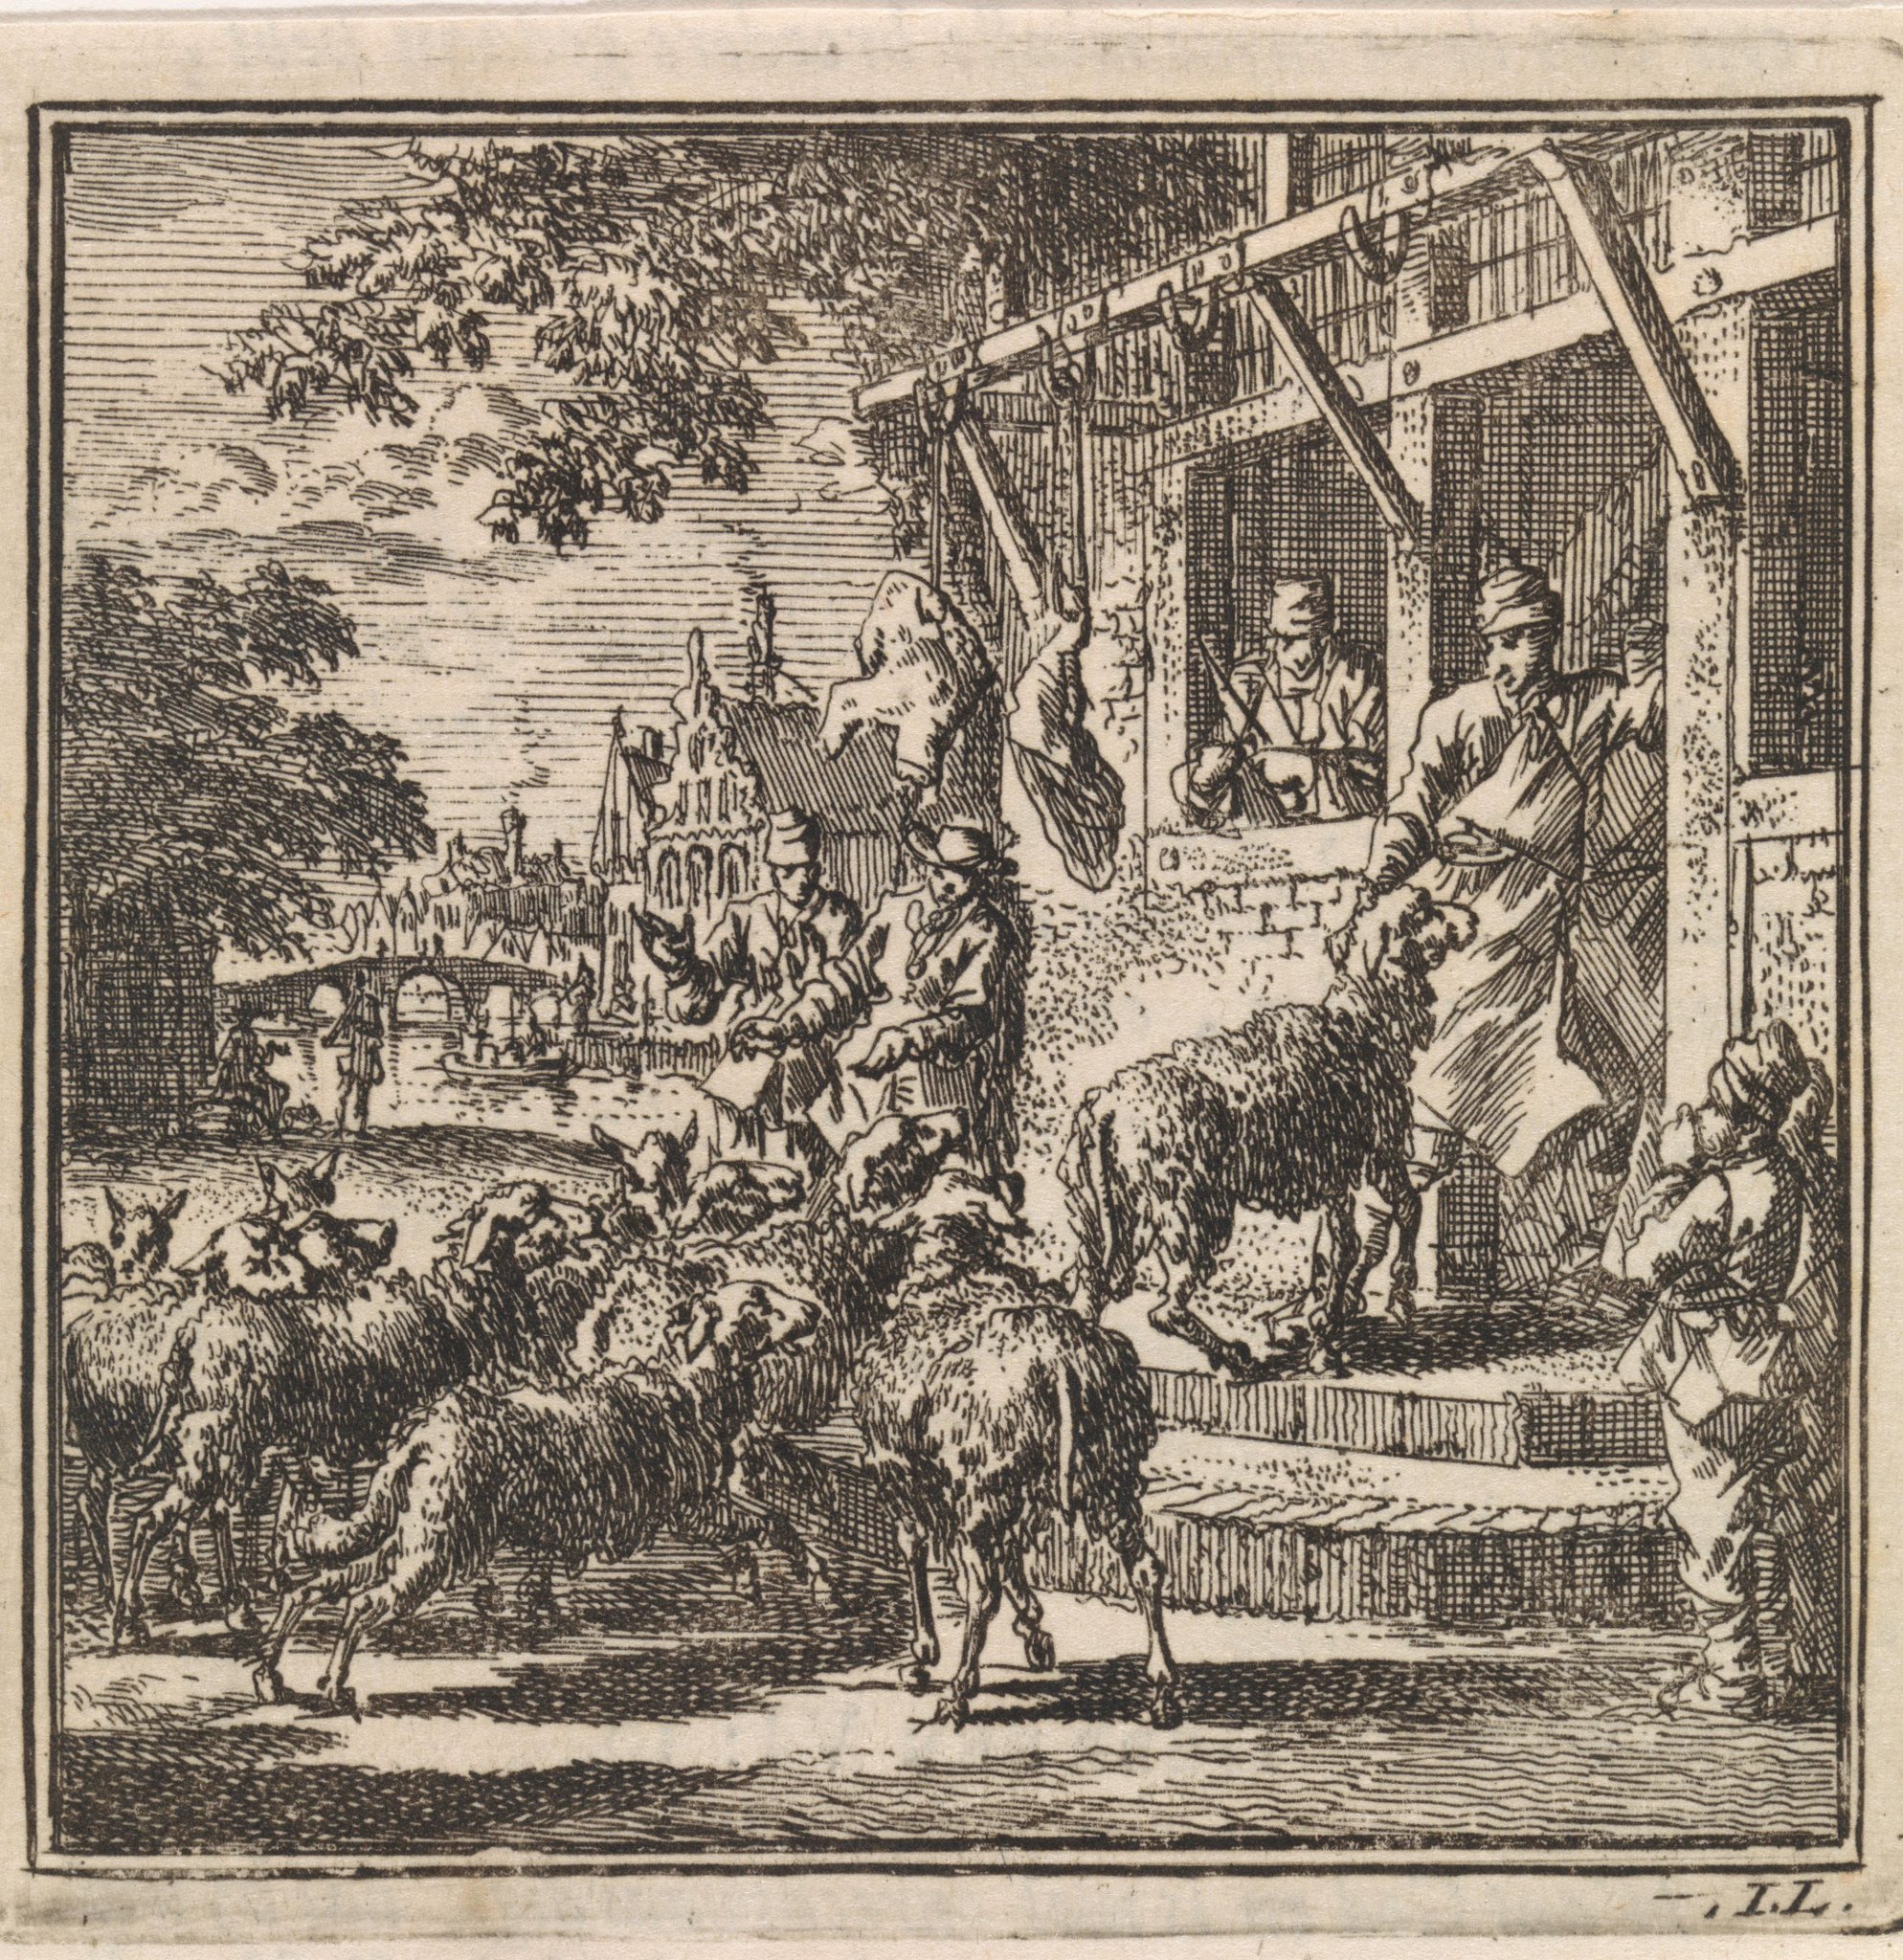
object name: print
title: Het Slagers Huis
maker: jan luyken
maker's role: draughtsman, print maker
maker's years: 1649-1712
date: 1711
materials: paper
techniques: etching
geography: amsterdam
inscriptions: collector's mark: Lugt 2228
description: Illustratie voor: Luyken, Jan. De Bykorf des Gemoeds. Amsterdam: Pieter Arentsz. II (wed.) en Cornelis van der Sys, 1711, p. 210.